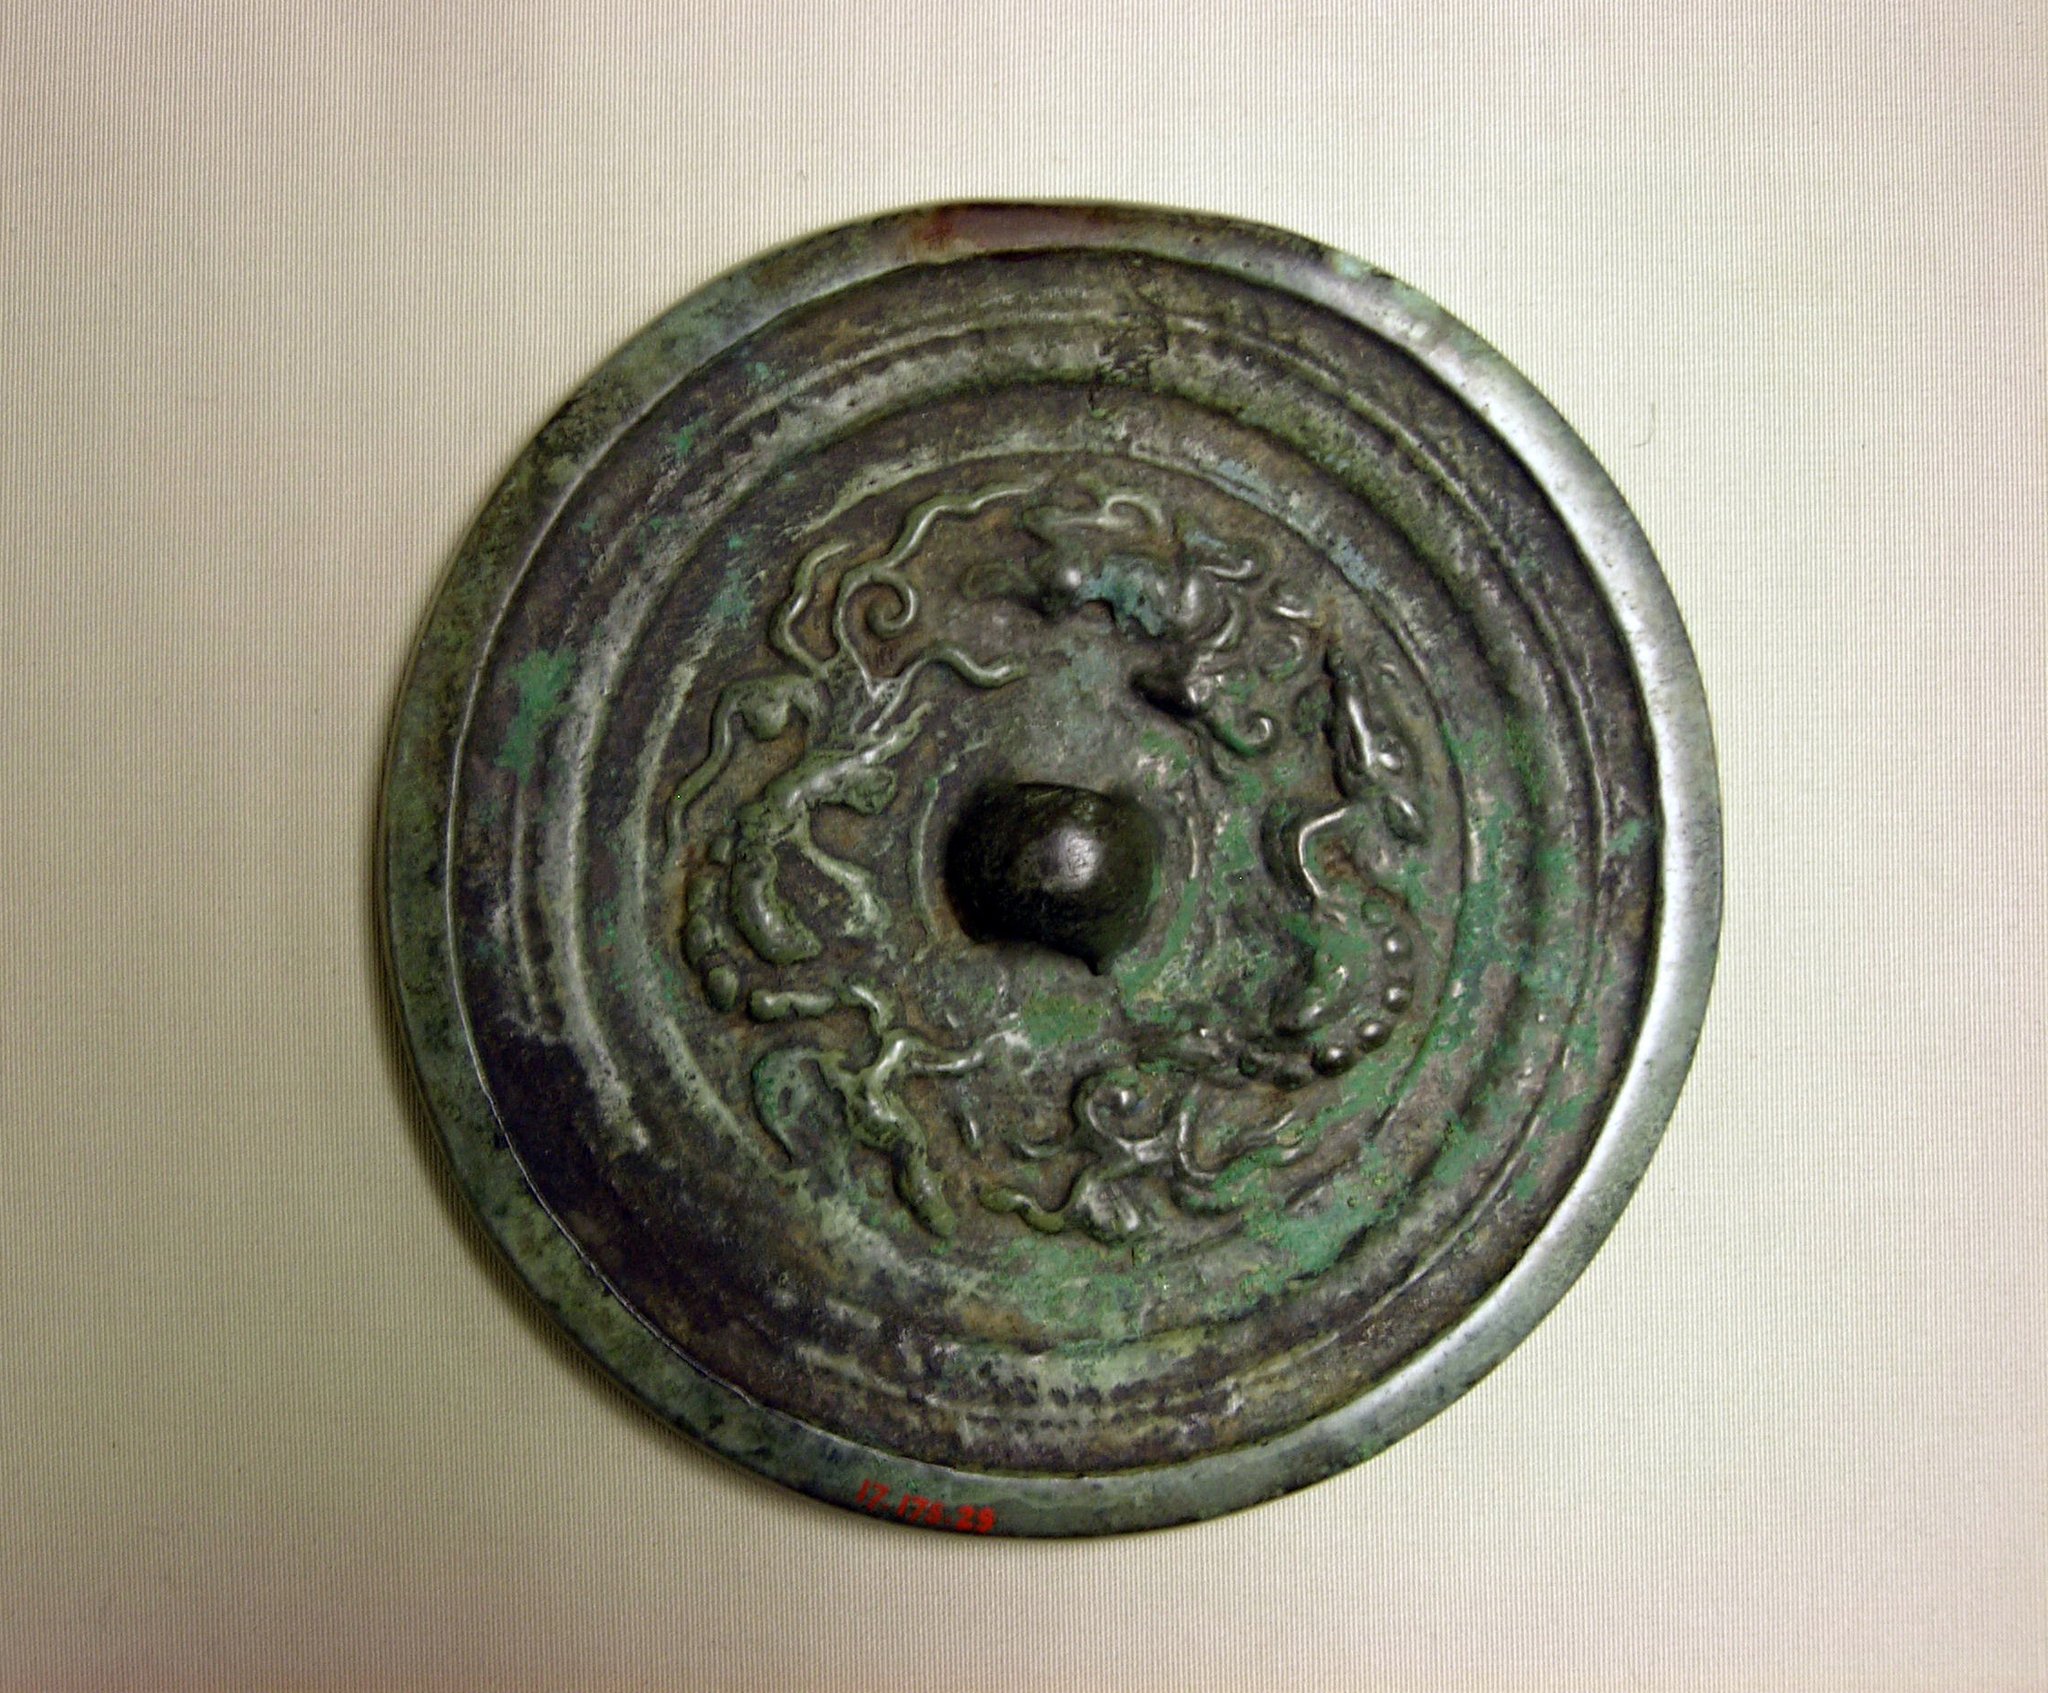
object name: mirror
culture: korean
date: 918-1392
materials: bronze